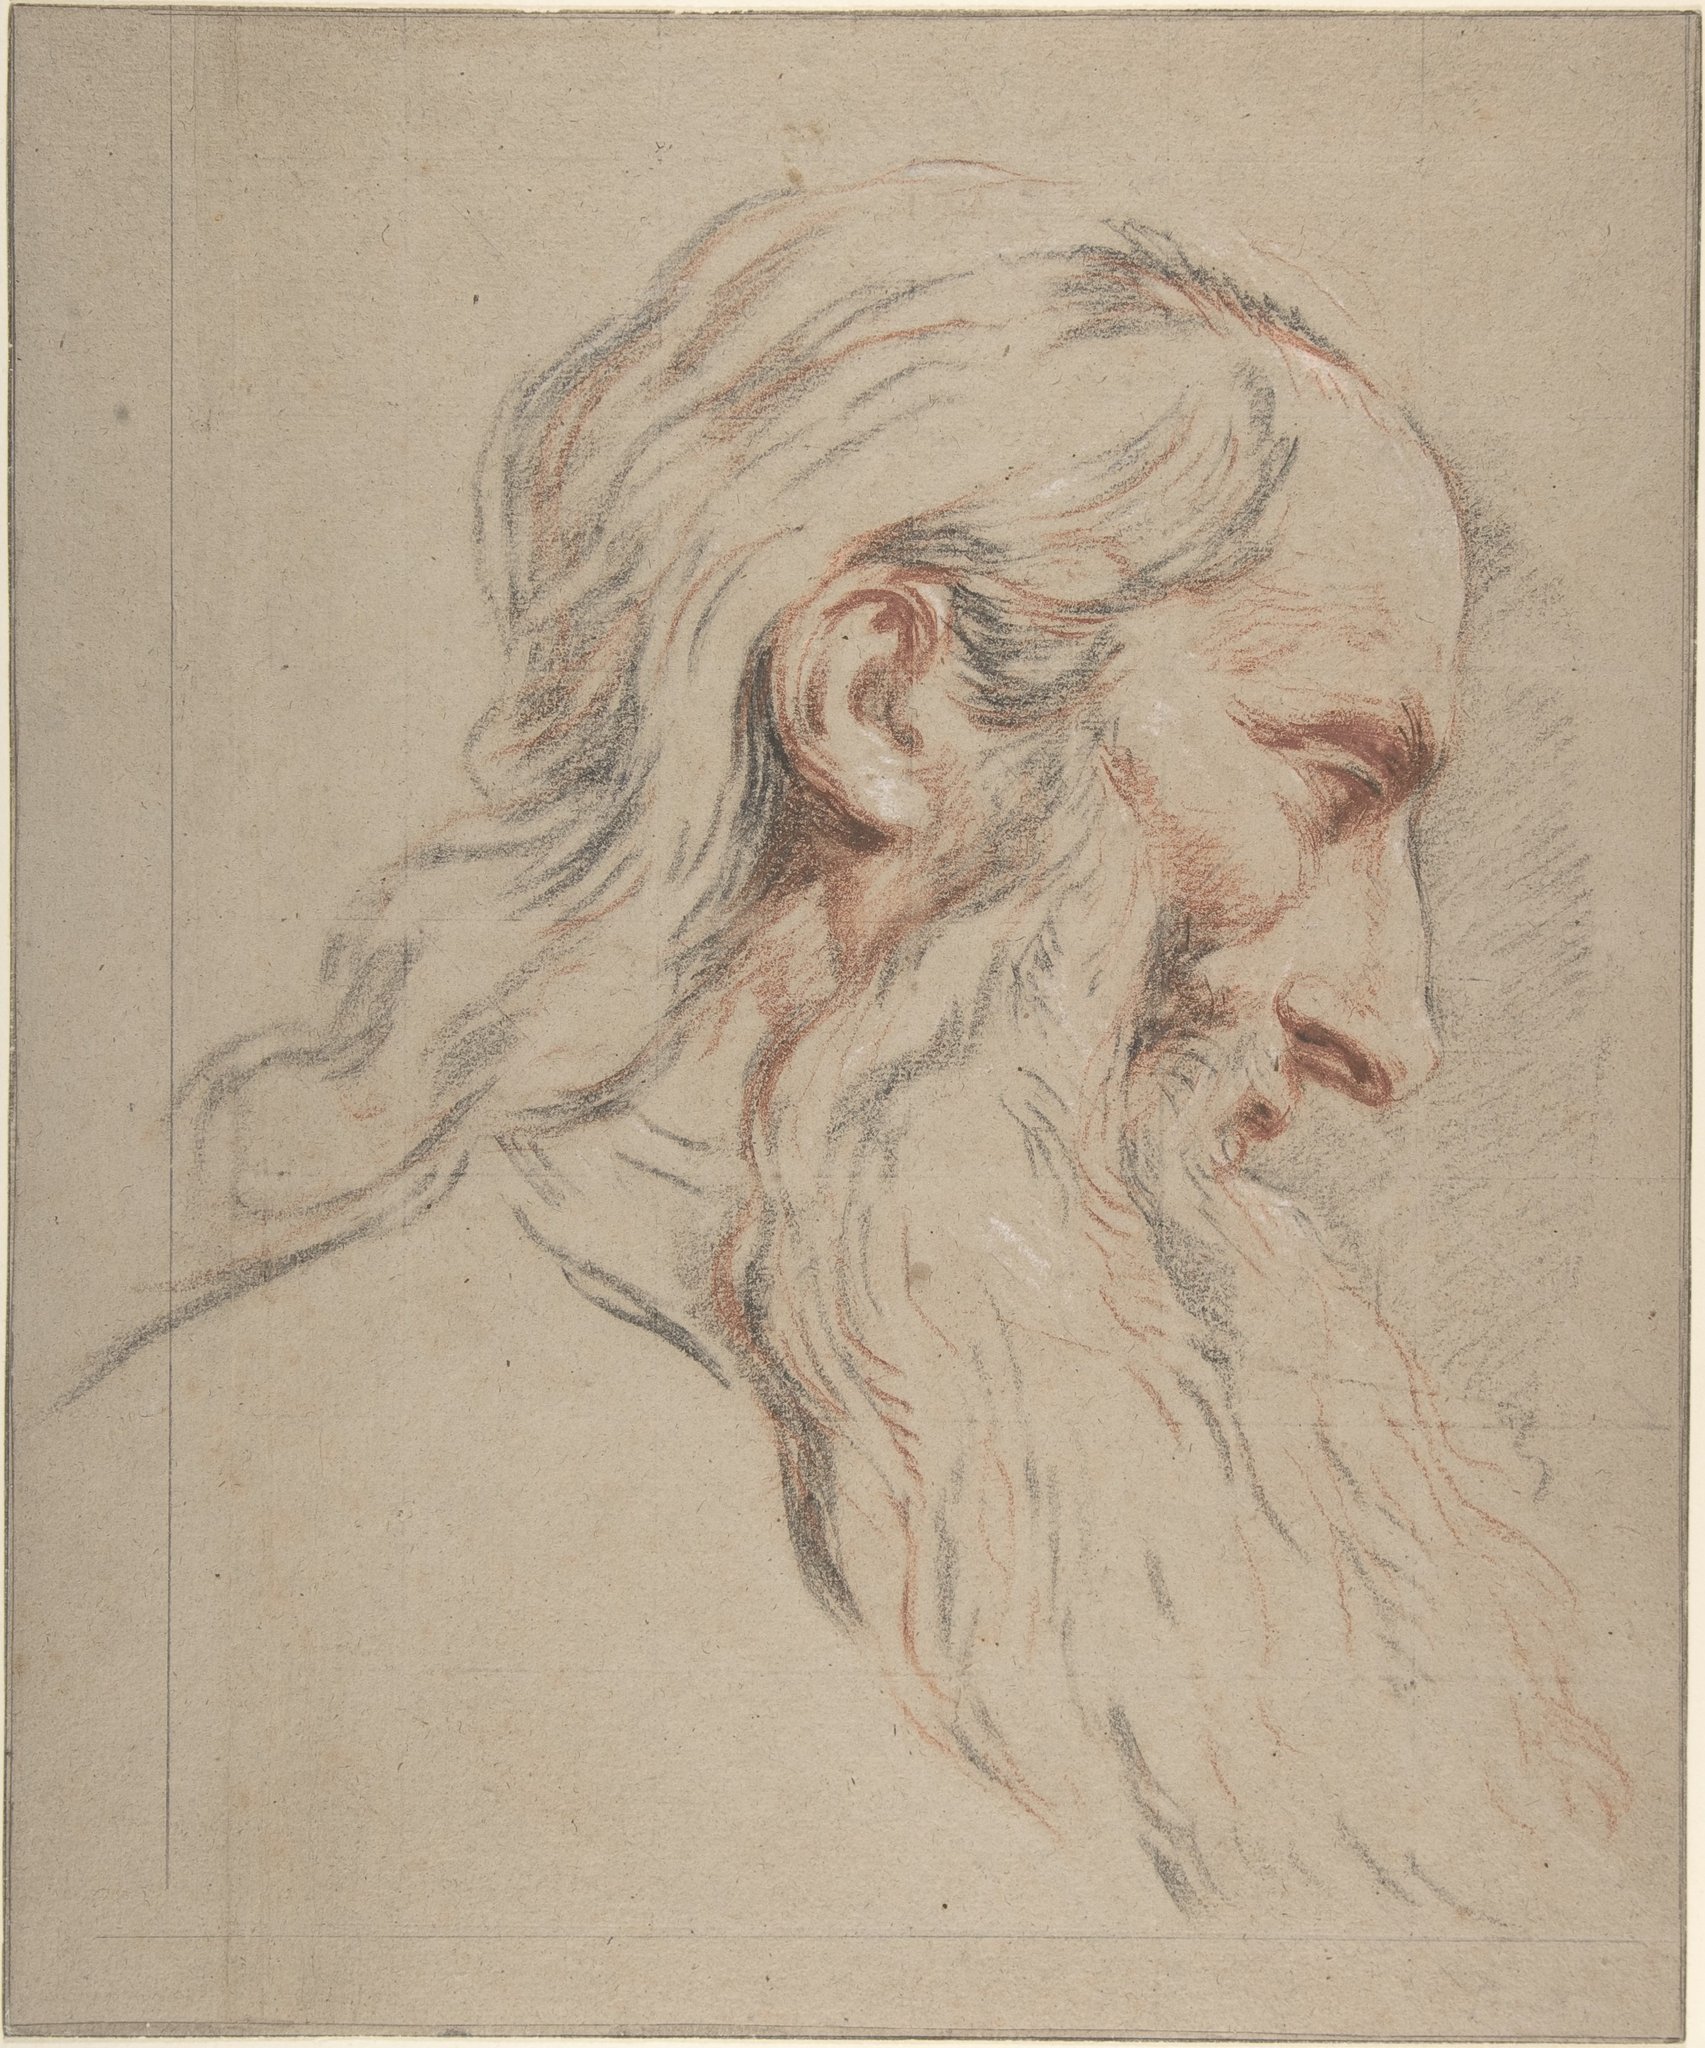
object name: drawing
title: Head of a Bearded Man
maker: jean restout le jeune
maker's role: artist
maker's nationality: french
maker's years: 1692-1768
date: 1750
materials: chalk, graphite, paper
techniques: heightening, drawing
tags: heads,men,profiles